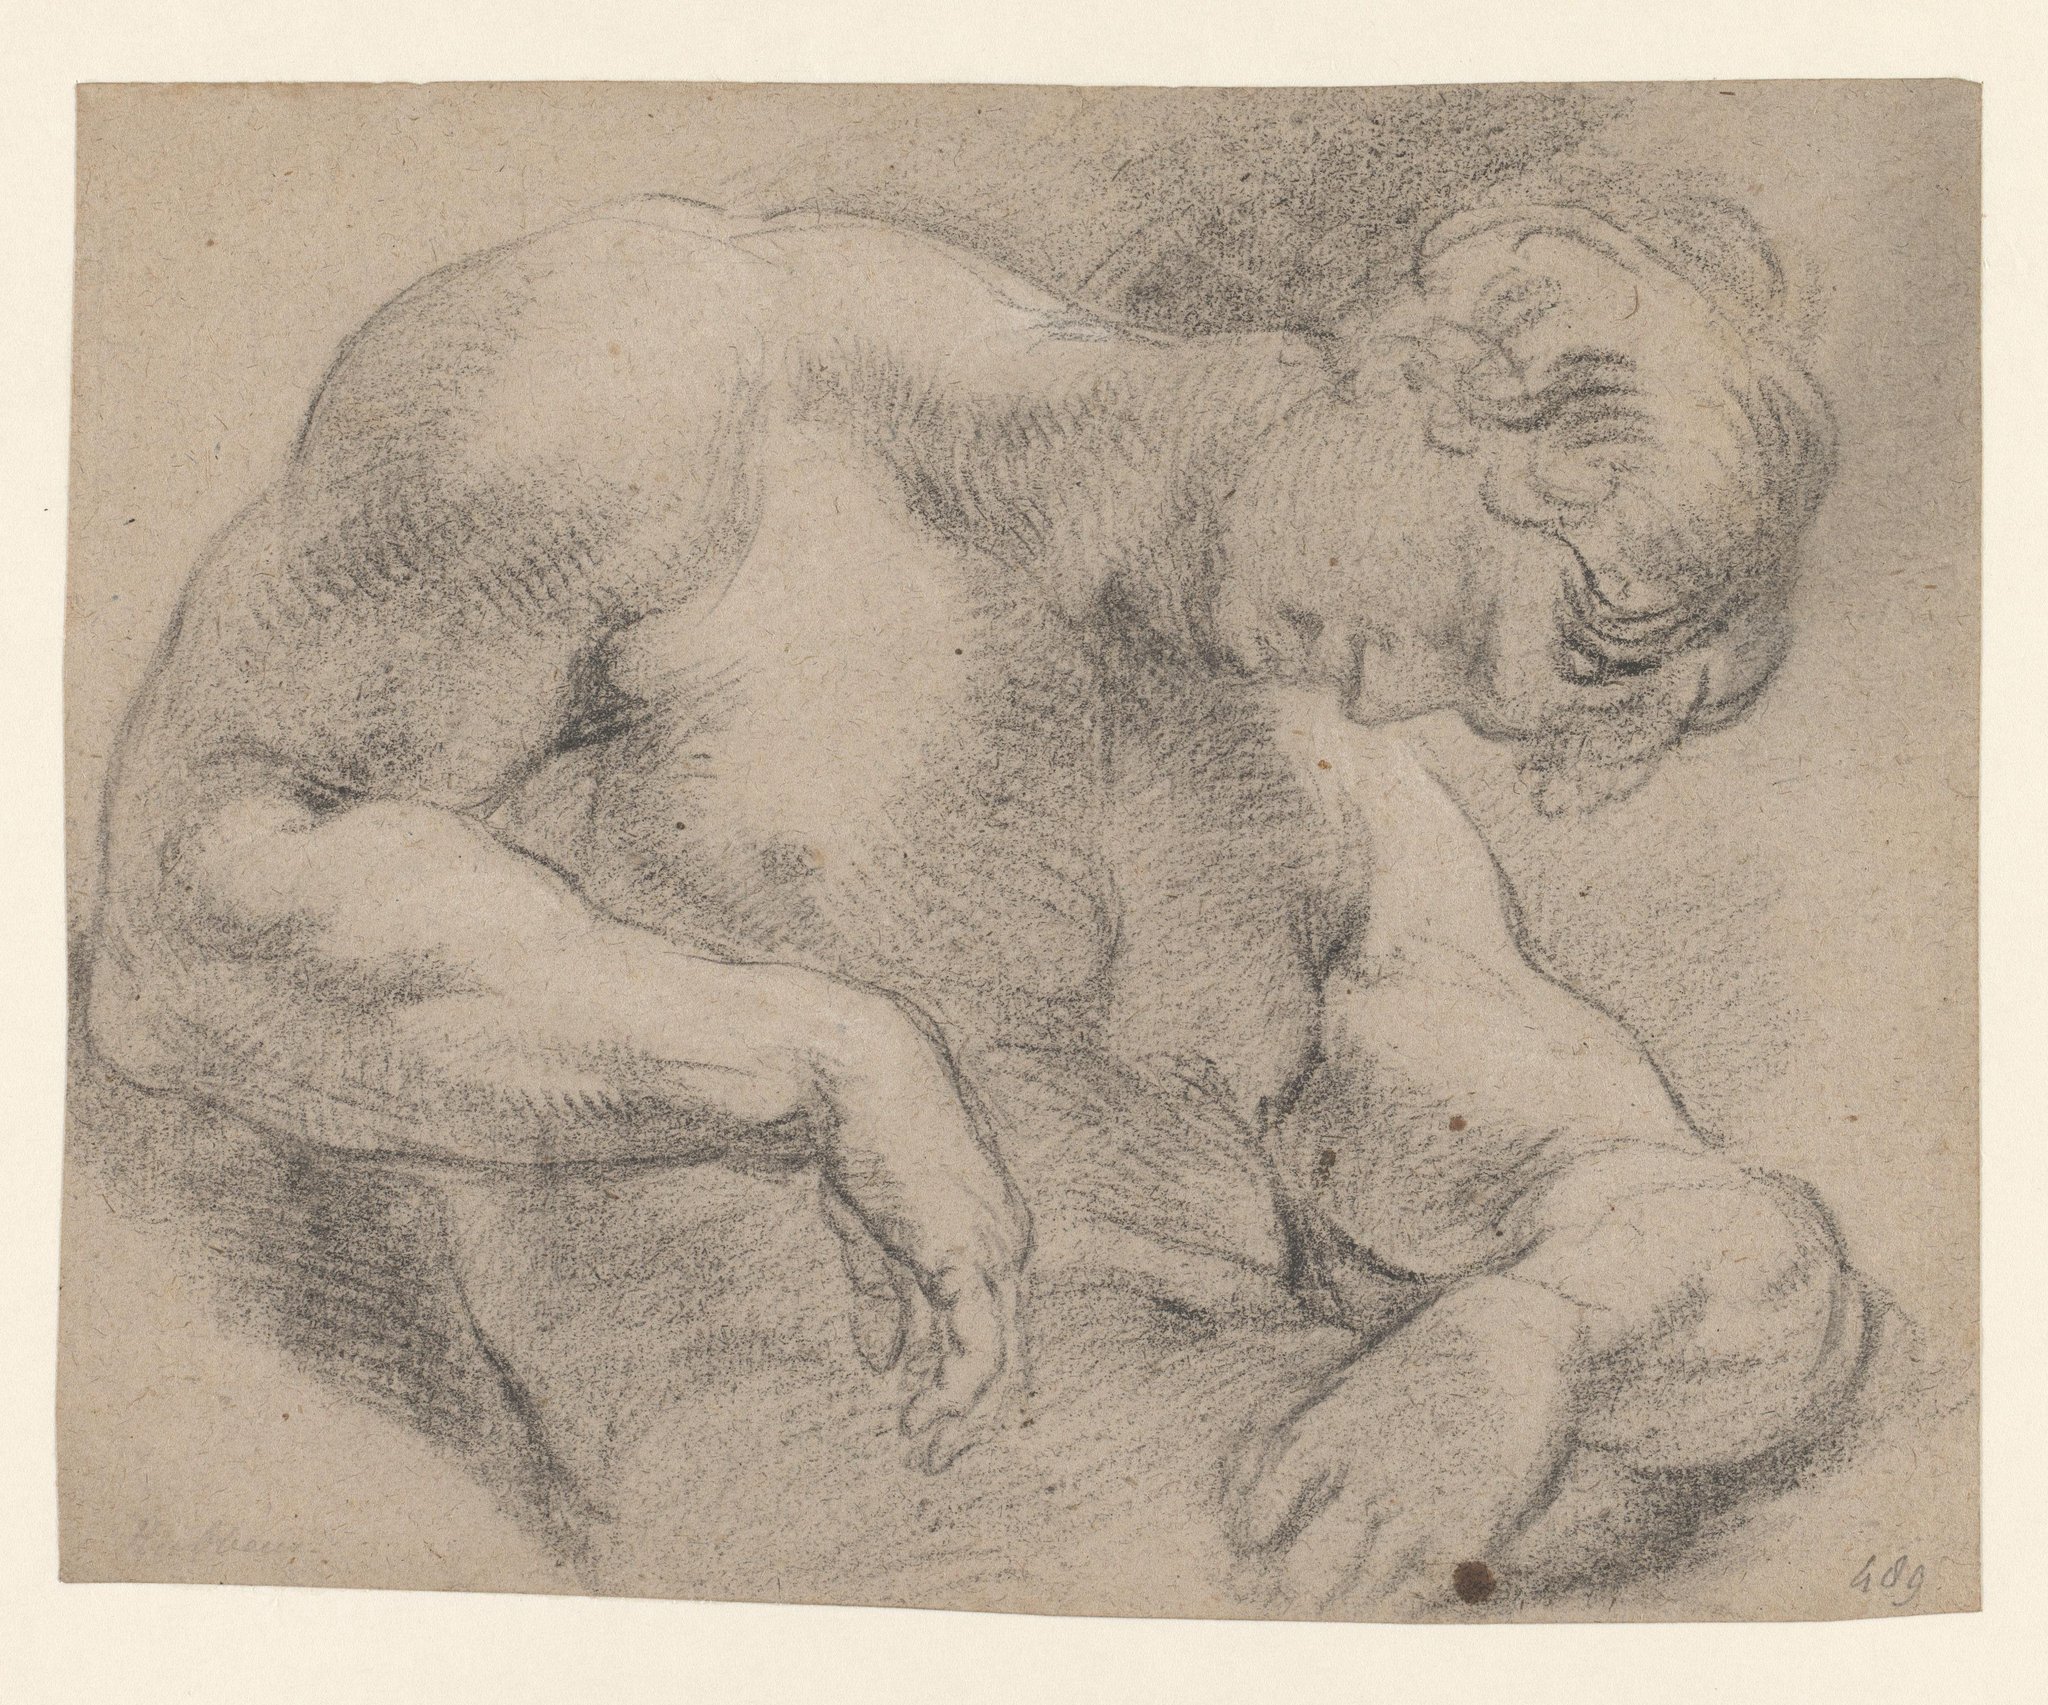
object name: drawing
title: Naaktfiguur met gebogen hoofd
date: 1616-1669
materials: chalk, paper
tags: male sex; man